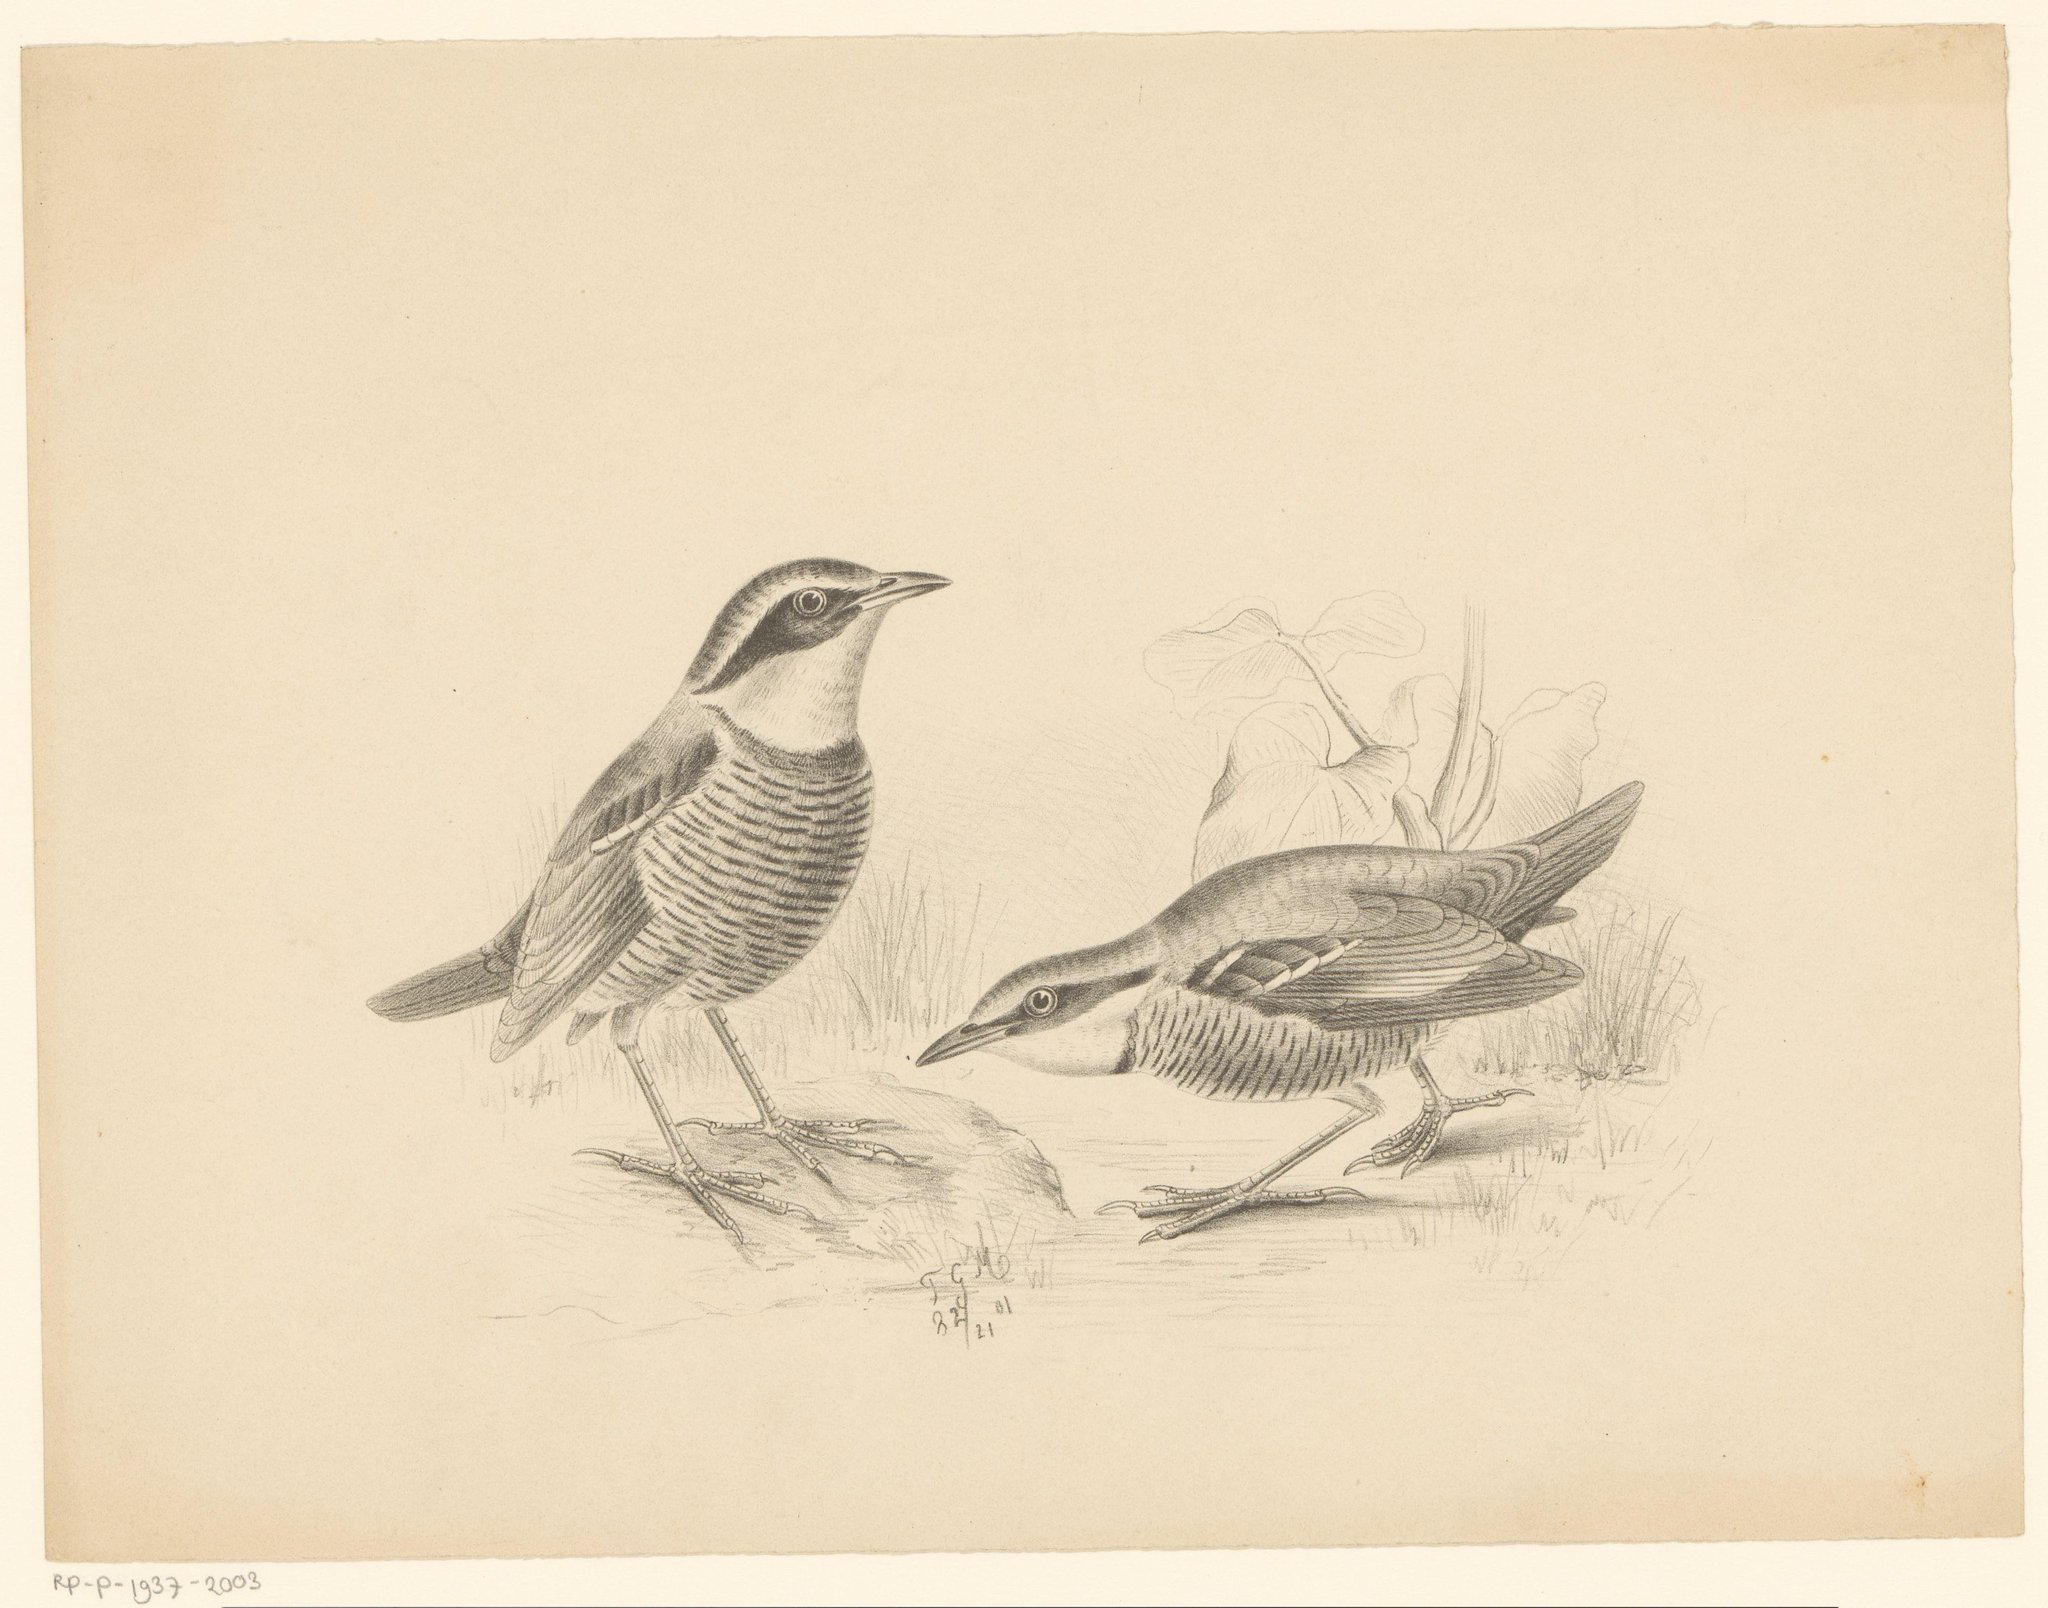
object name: print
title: Twee vogels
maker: Anonymous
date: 1882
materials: paper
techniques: lithograph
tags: song-birds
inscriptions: monogram: ‘TGM’, collector's mark: Lugt 2760, collector's mark: 2228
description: De vogels staan naast elkaar op de grond.